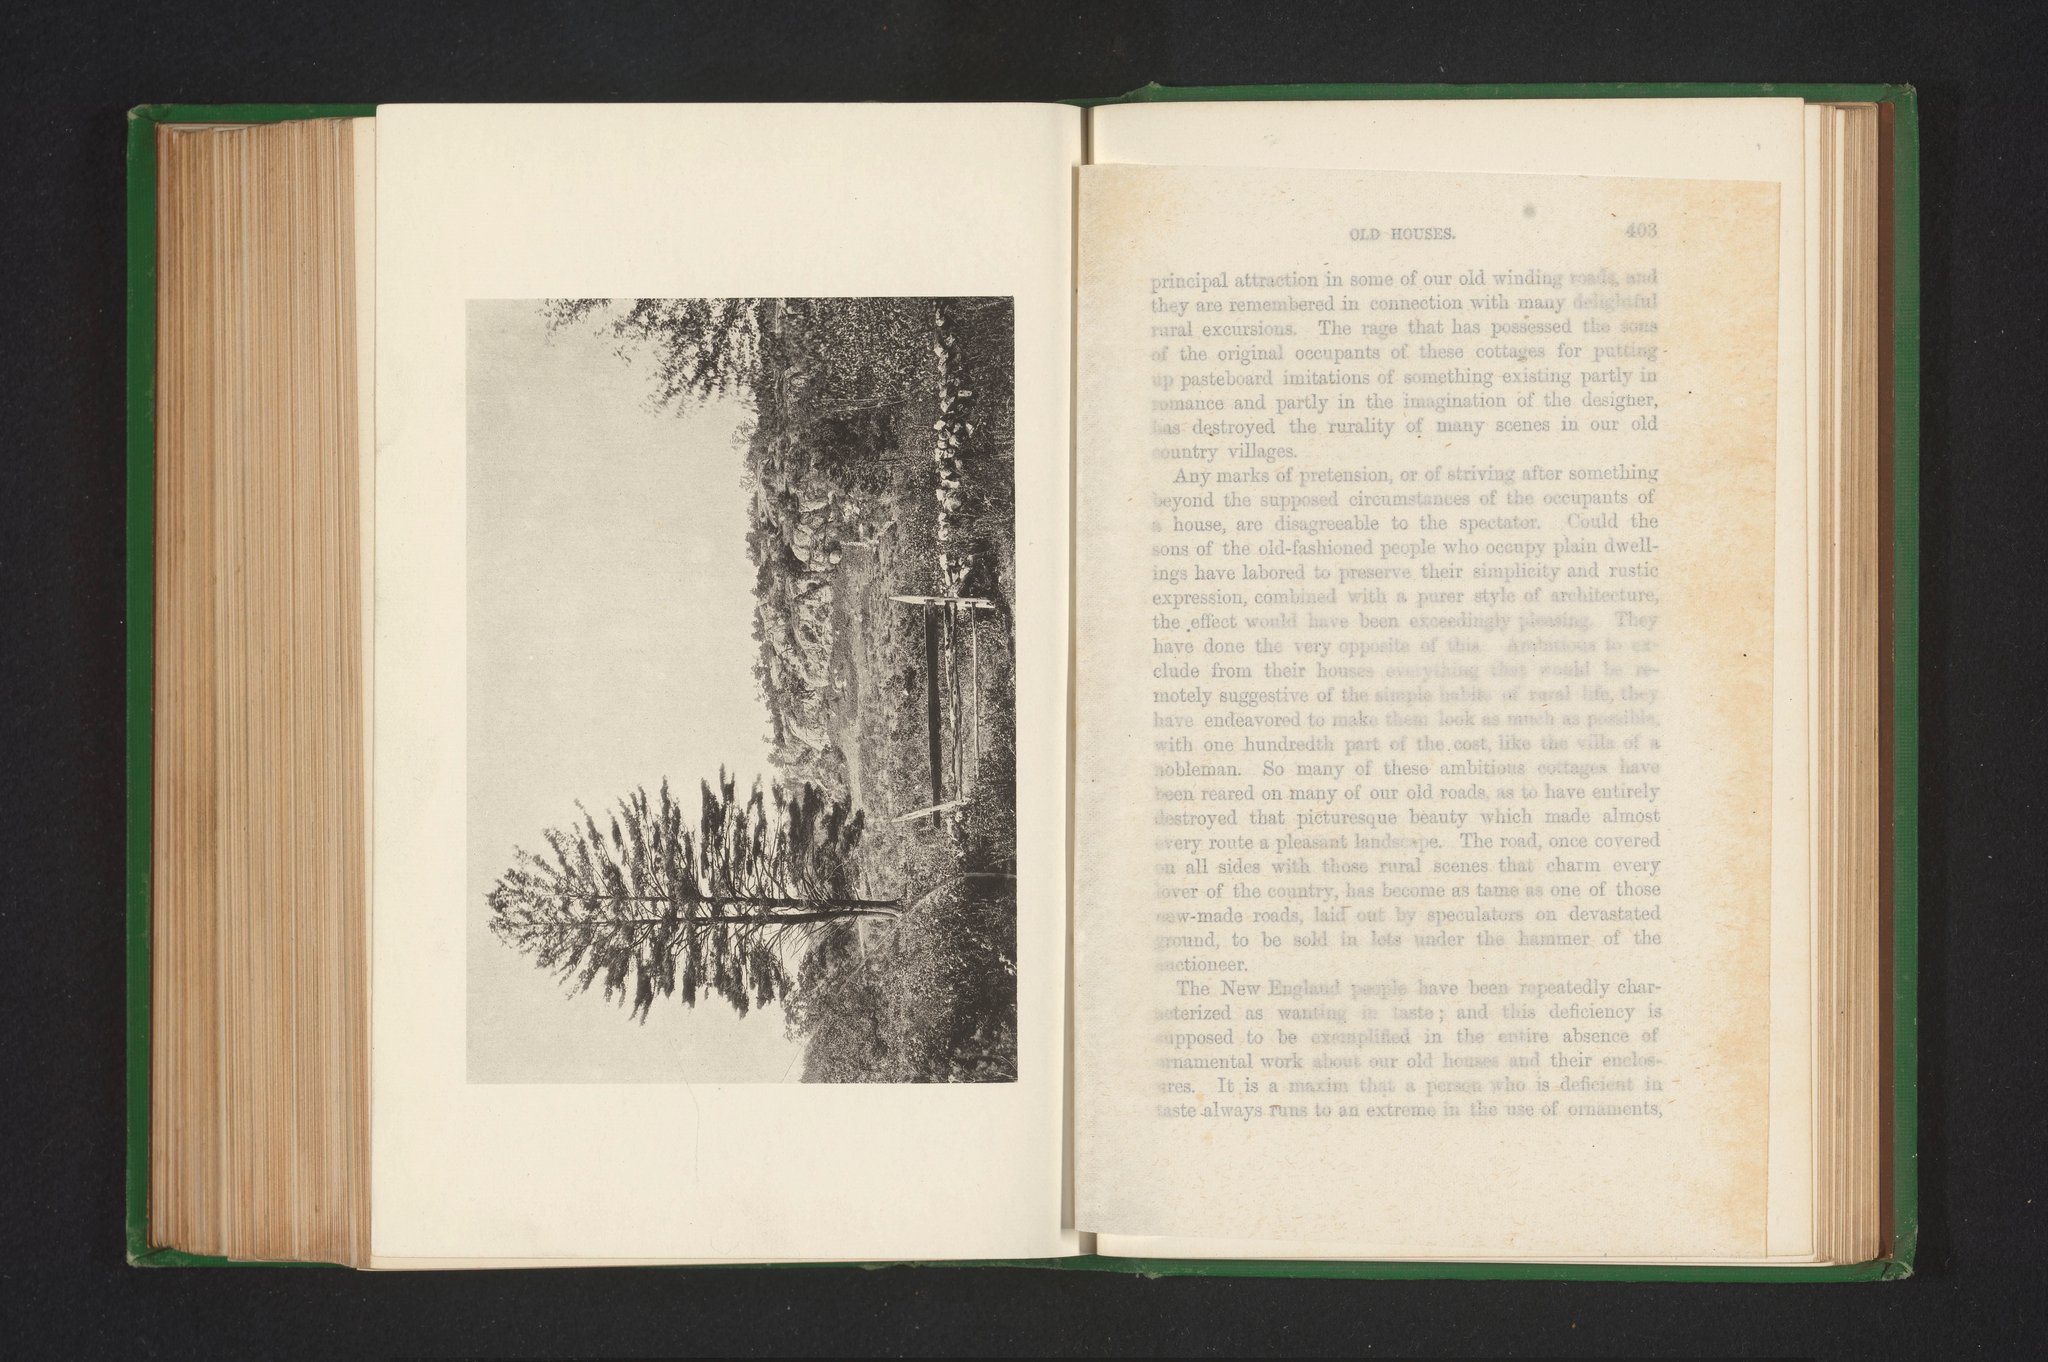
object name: page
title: Landschap te Andover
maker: Anonymous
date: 1875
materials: paper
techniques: photograph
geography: andover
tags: landscapes, fence, wall, paling, rocks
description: Prent op tweede ongenummerde pagina na pagina 402.